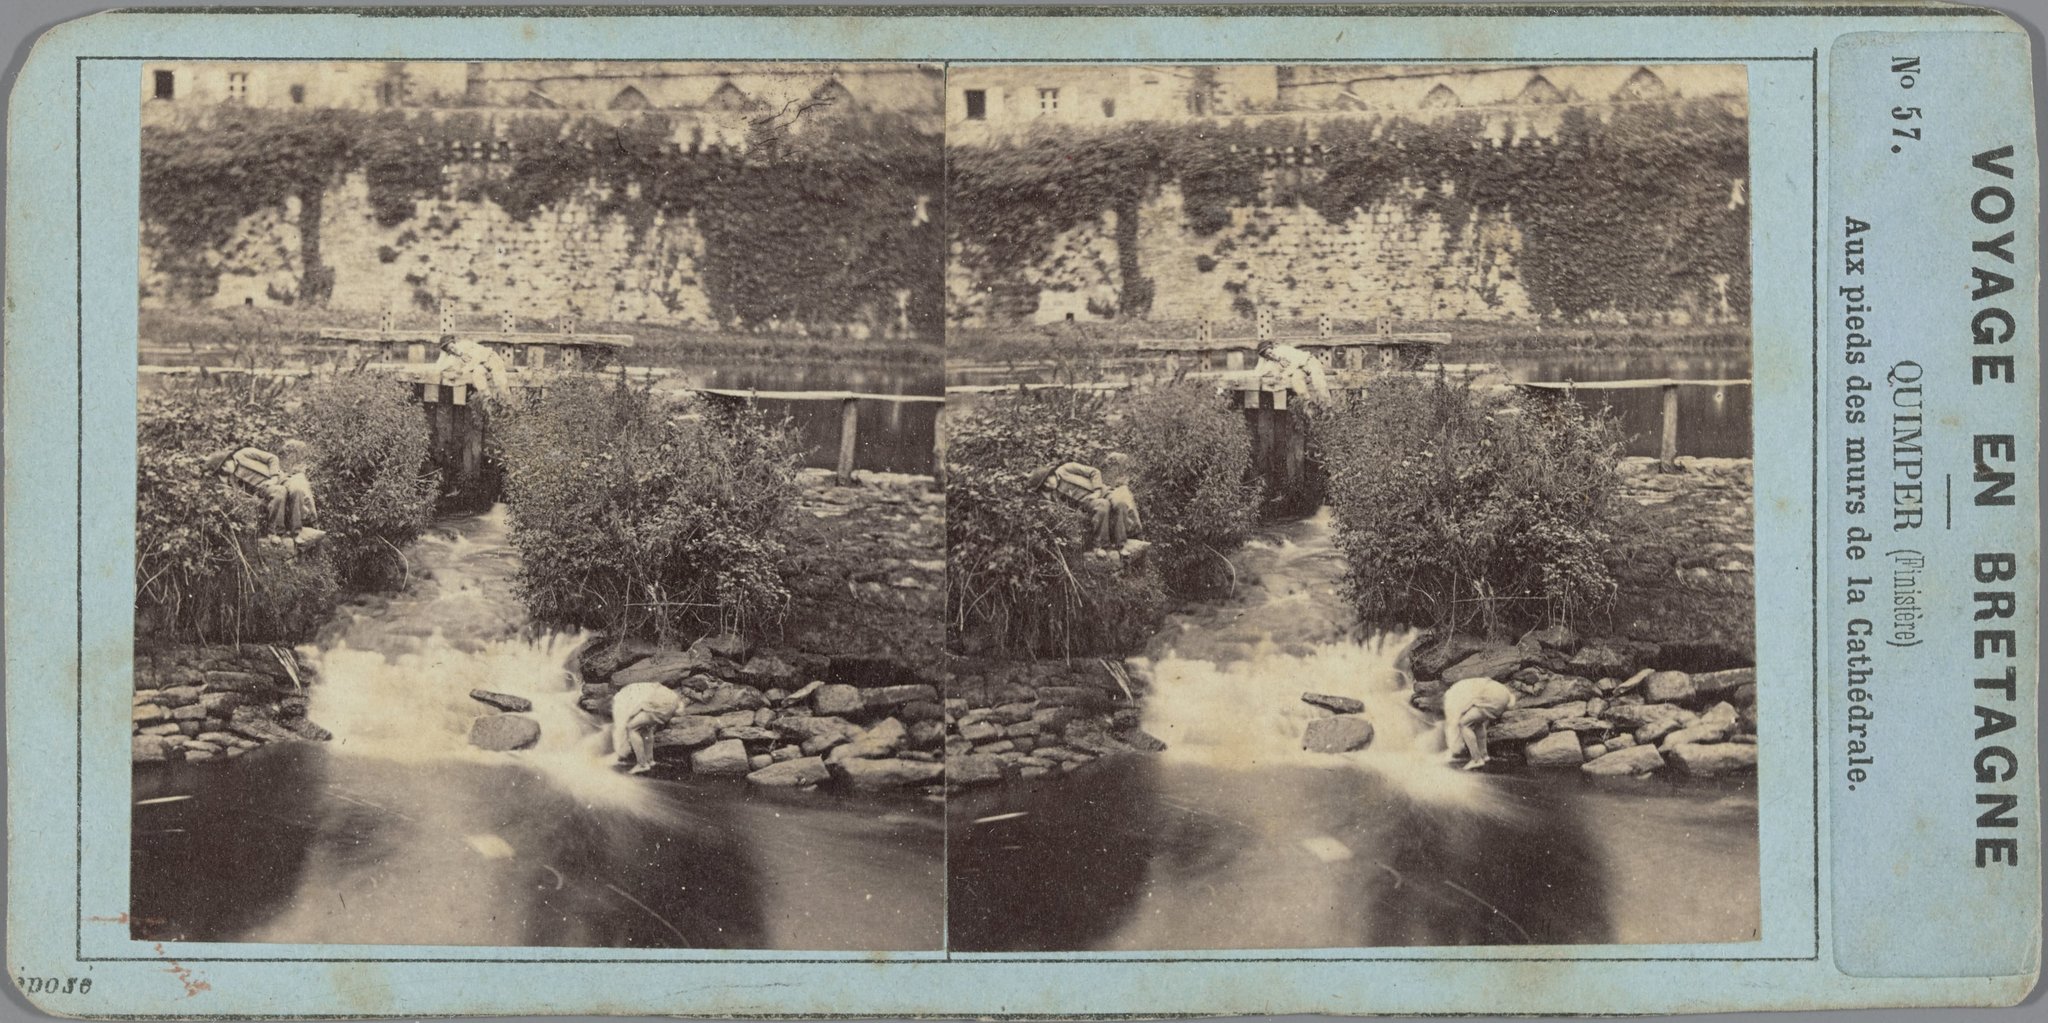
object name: stereograph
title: Spelende kinderen aan de waterkant bij de kathedraal van Quimper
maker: Anonymous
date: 1860-1880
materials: cardboard, paper, photographic support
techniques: albumen print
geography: quimper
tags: child and nature (games and plays)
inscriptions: number: ‘No. 57.’